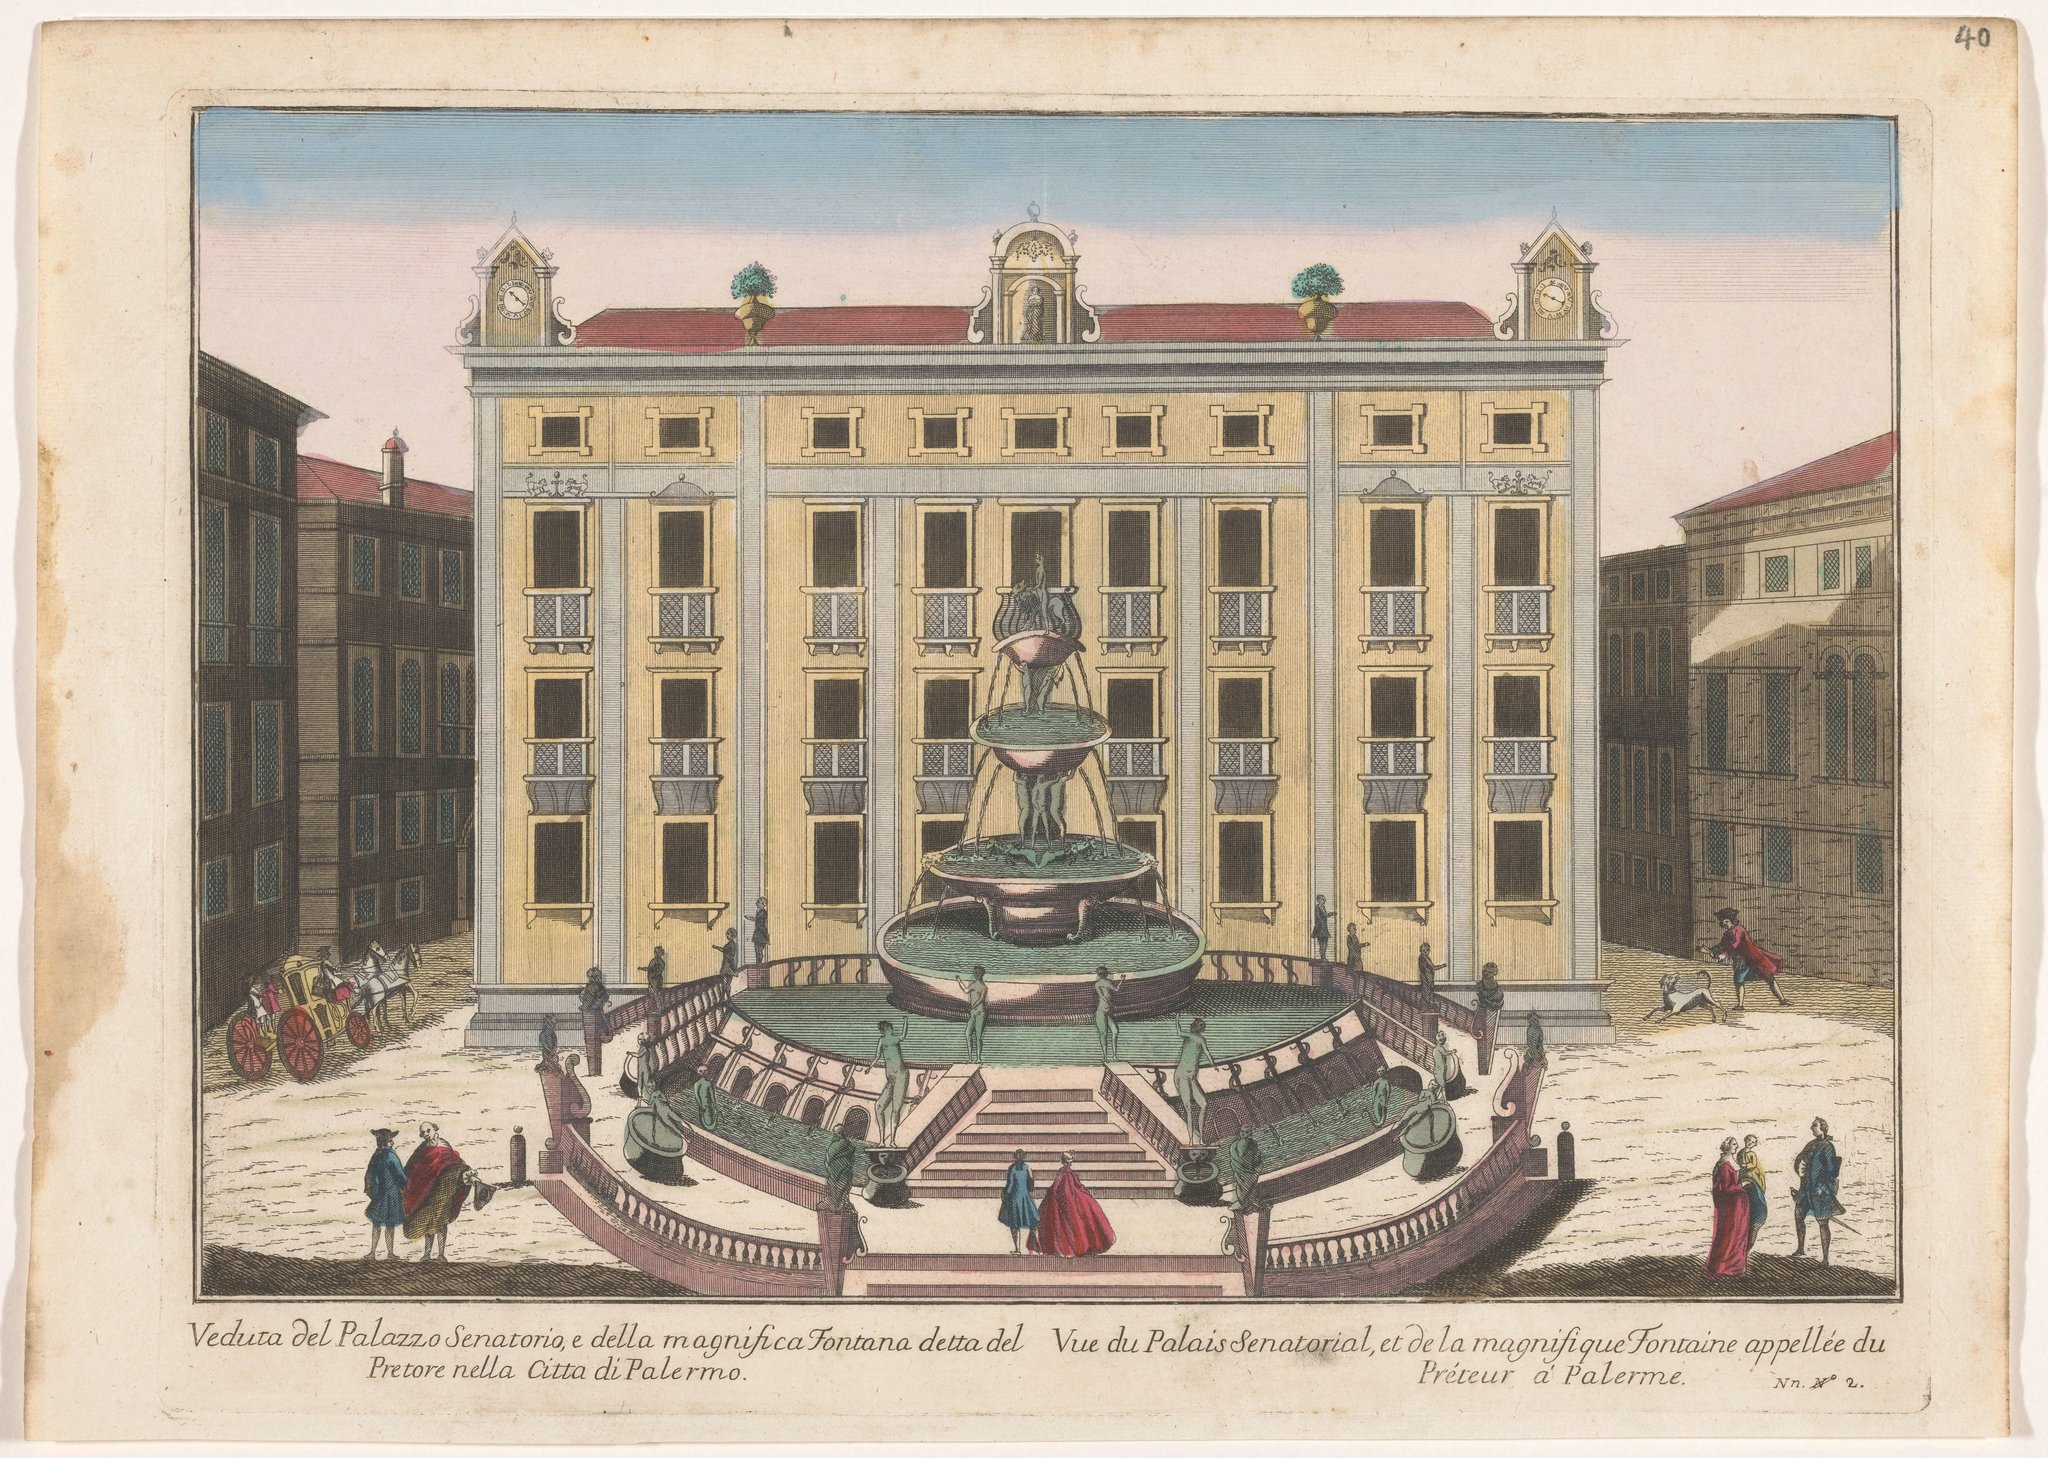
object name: print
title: Gezicht op het Palazzo Senatorio te Palermo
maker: Anonymous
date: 1700-1799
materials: paper, watercolor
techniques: brush, etching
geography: bassano del grappa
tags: palace, square, place, circus, etc. (+ city(-scape) with figures, staffage), ornamental fountain (+ city(-scape) with figures, staffage)